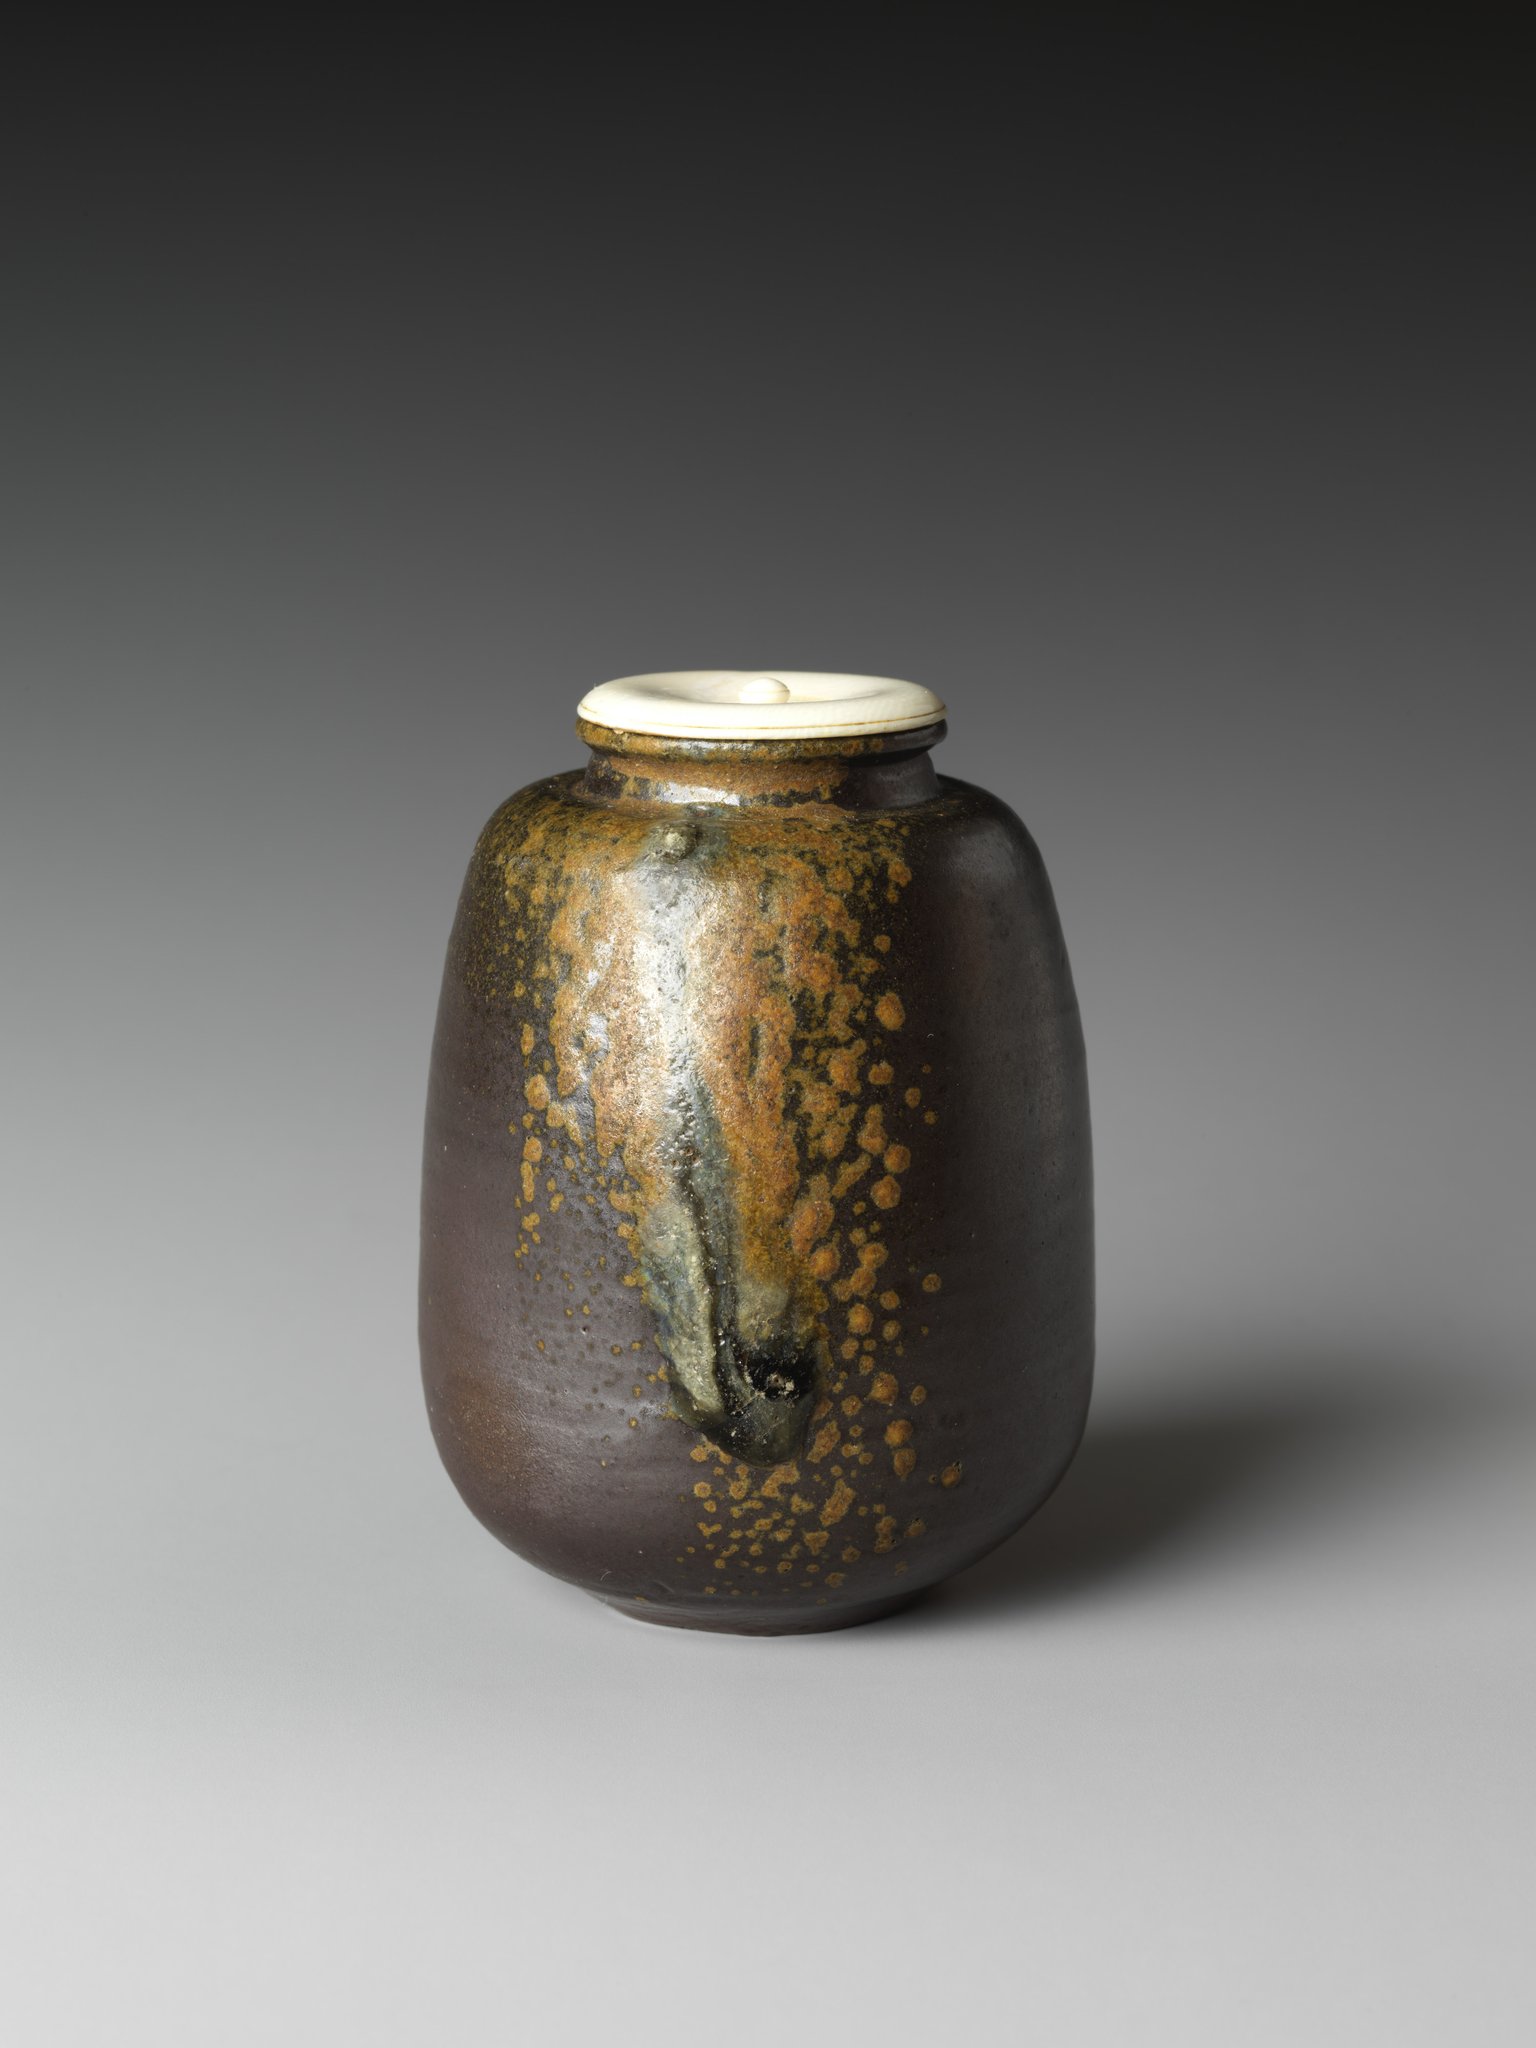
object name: tea caddy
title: Tea Caddy (Chaire)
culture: japanese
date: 1601-1700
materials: wood, glaze, stoneware